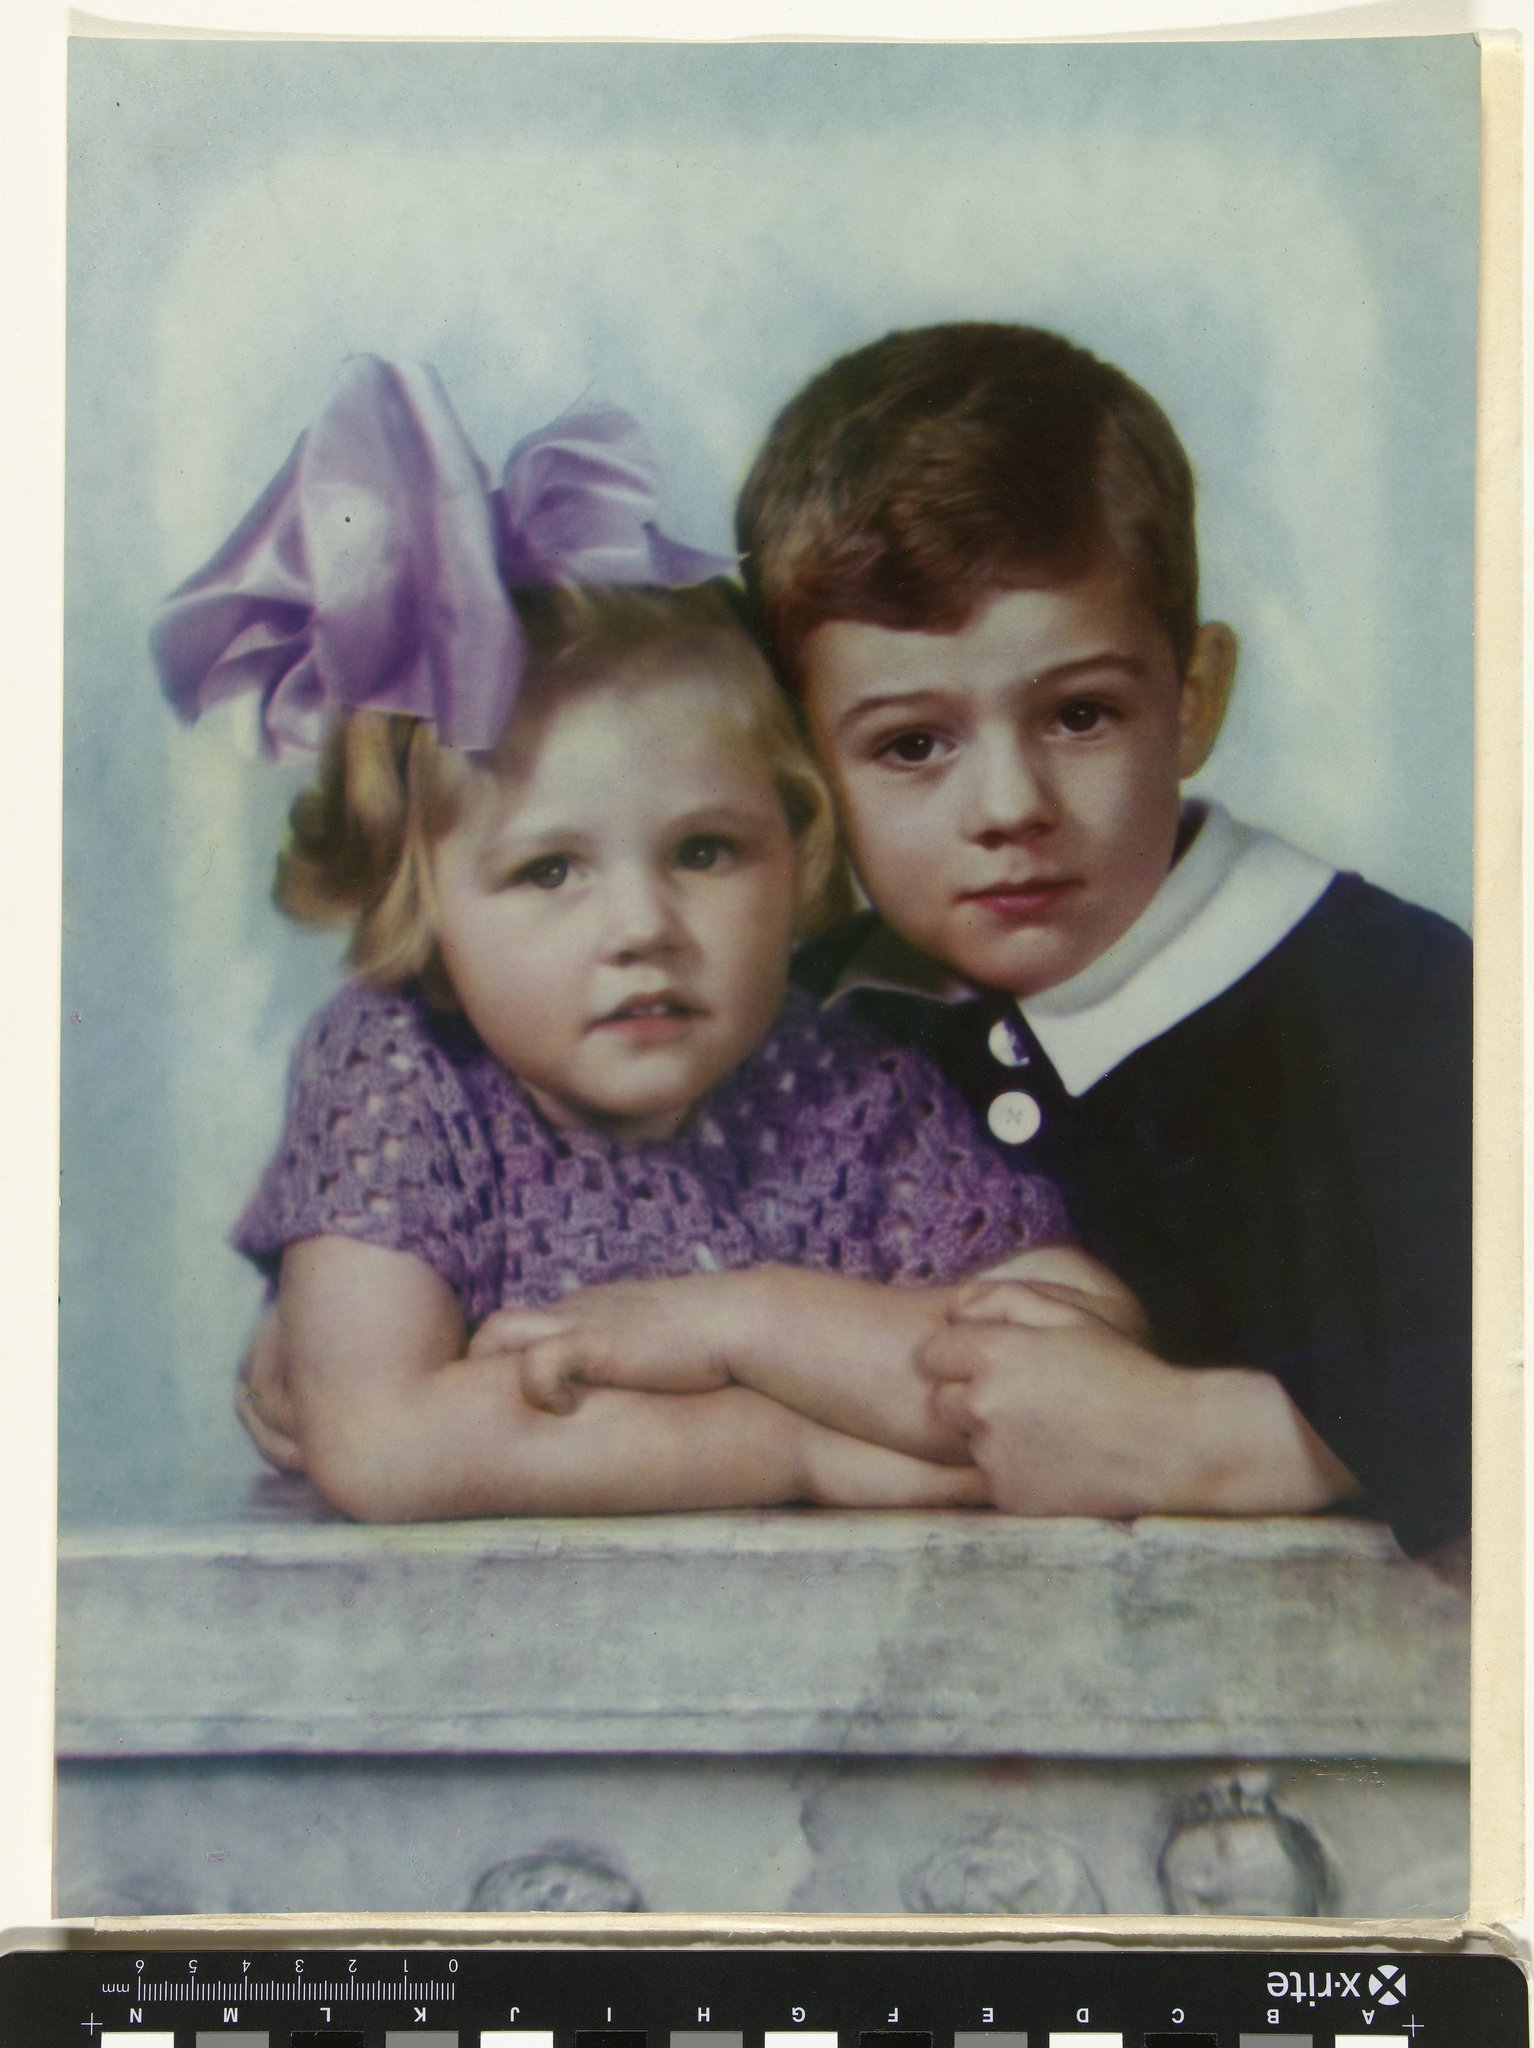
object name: photograph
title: Portret van een jongen en een meisje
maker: jacob merkelbach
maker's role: fotograaf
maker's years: 1877-1942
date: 1920-1930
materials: photographic support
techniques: jos-pé print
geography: amsterdam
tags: anonymous historical persons portrayed in a double portrait